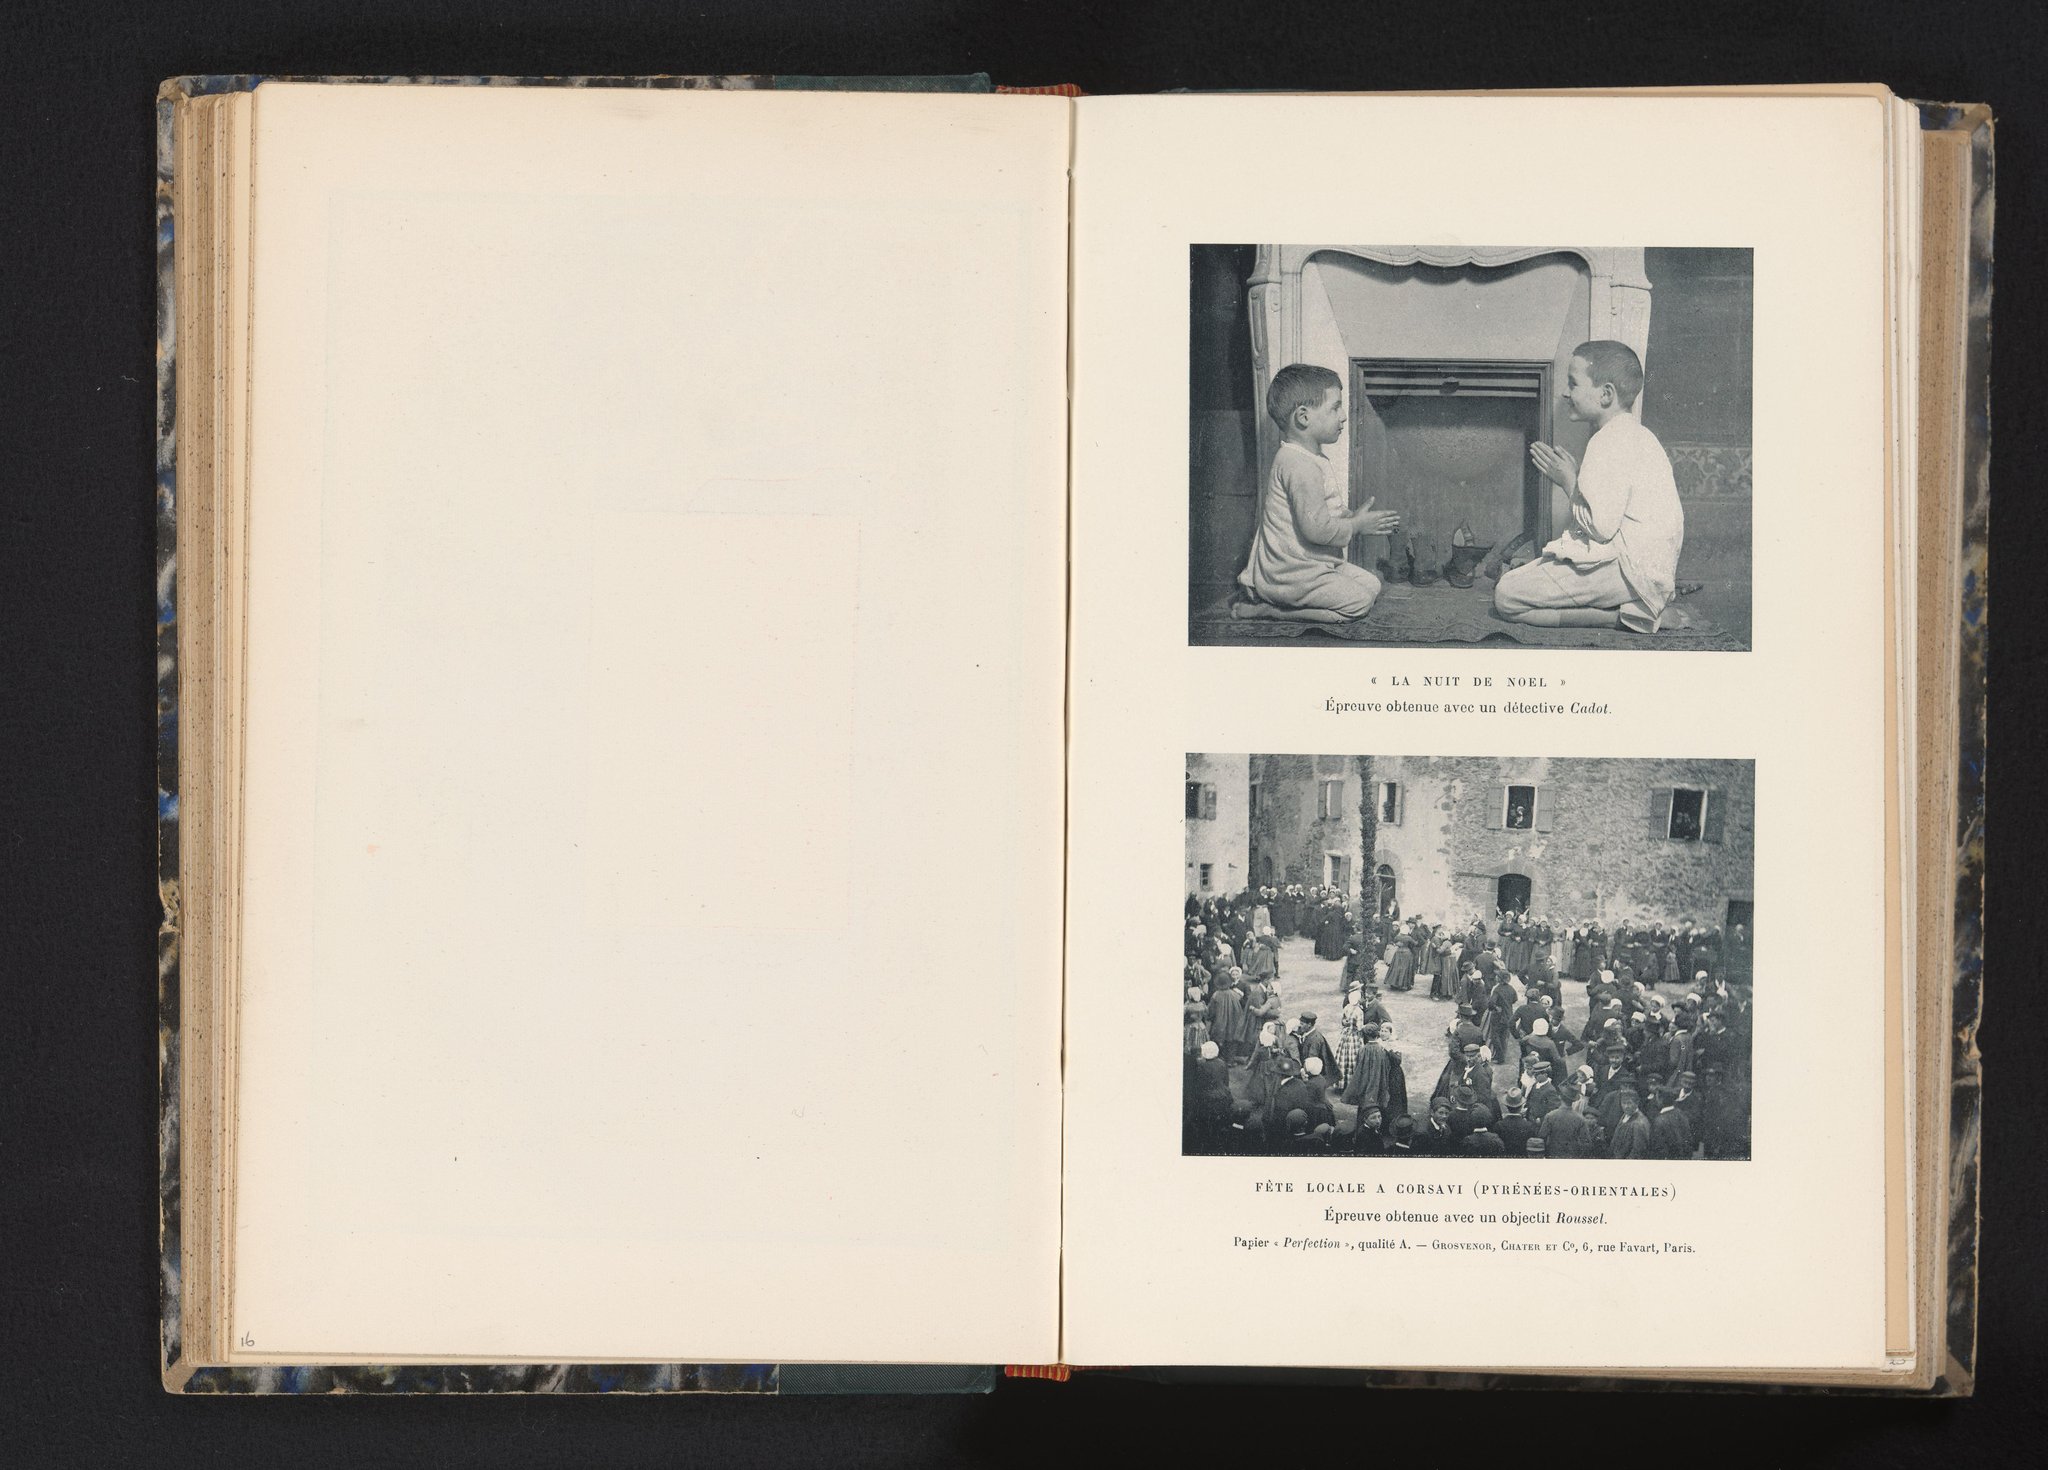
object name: page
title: Fête Locale a Corsavi (Pyrénées-Orientales)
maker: Anonymous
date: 1891-1896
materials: paper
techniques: autotype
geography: france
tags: christmas (non-liturgical celebration), boy (child between toddler and youth) (+ two persons), public festivities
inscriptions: inscription: ‘Épreuve obtenue avec un objectif Roussel./ Papier < Perfection >, qualité A. - Grosvenor, Chater et Co, 6, rue Favart, Paris.’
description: Prenten op vijfde ongenummerde pagina na pagina 102.